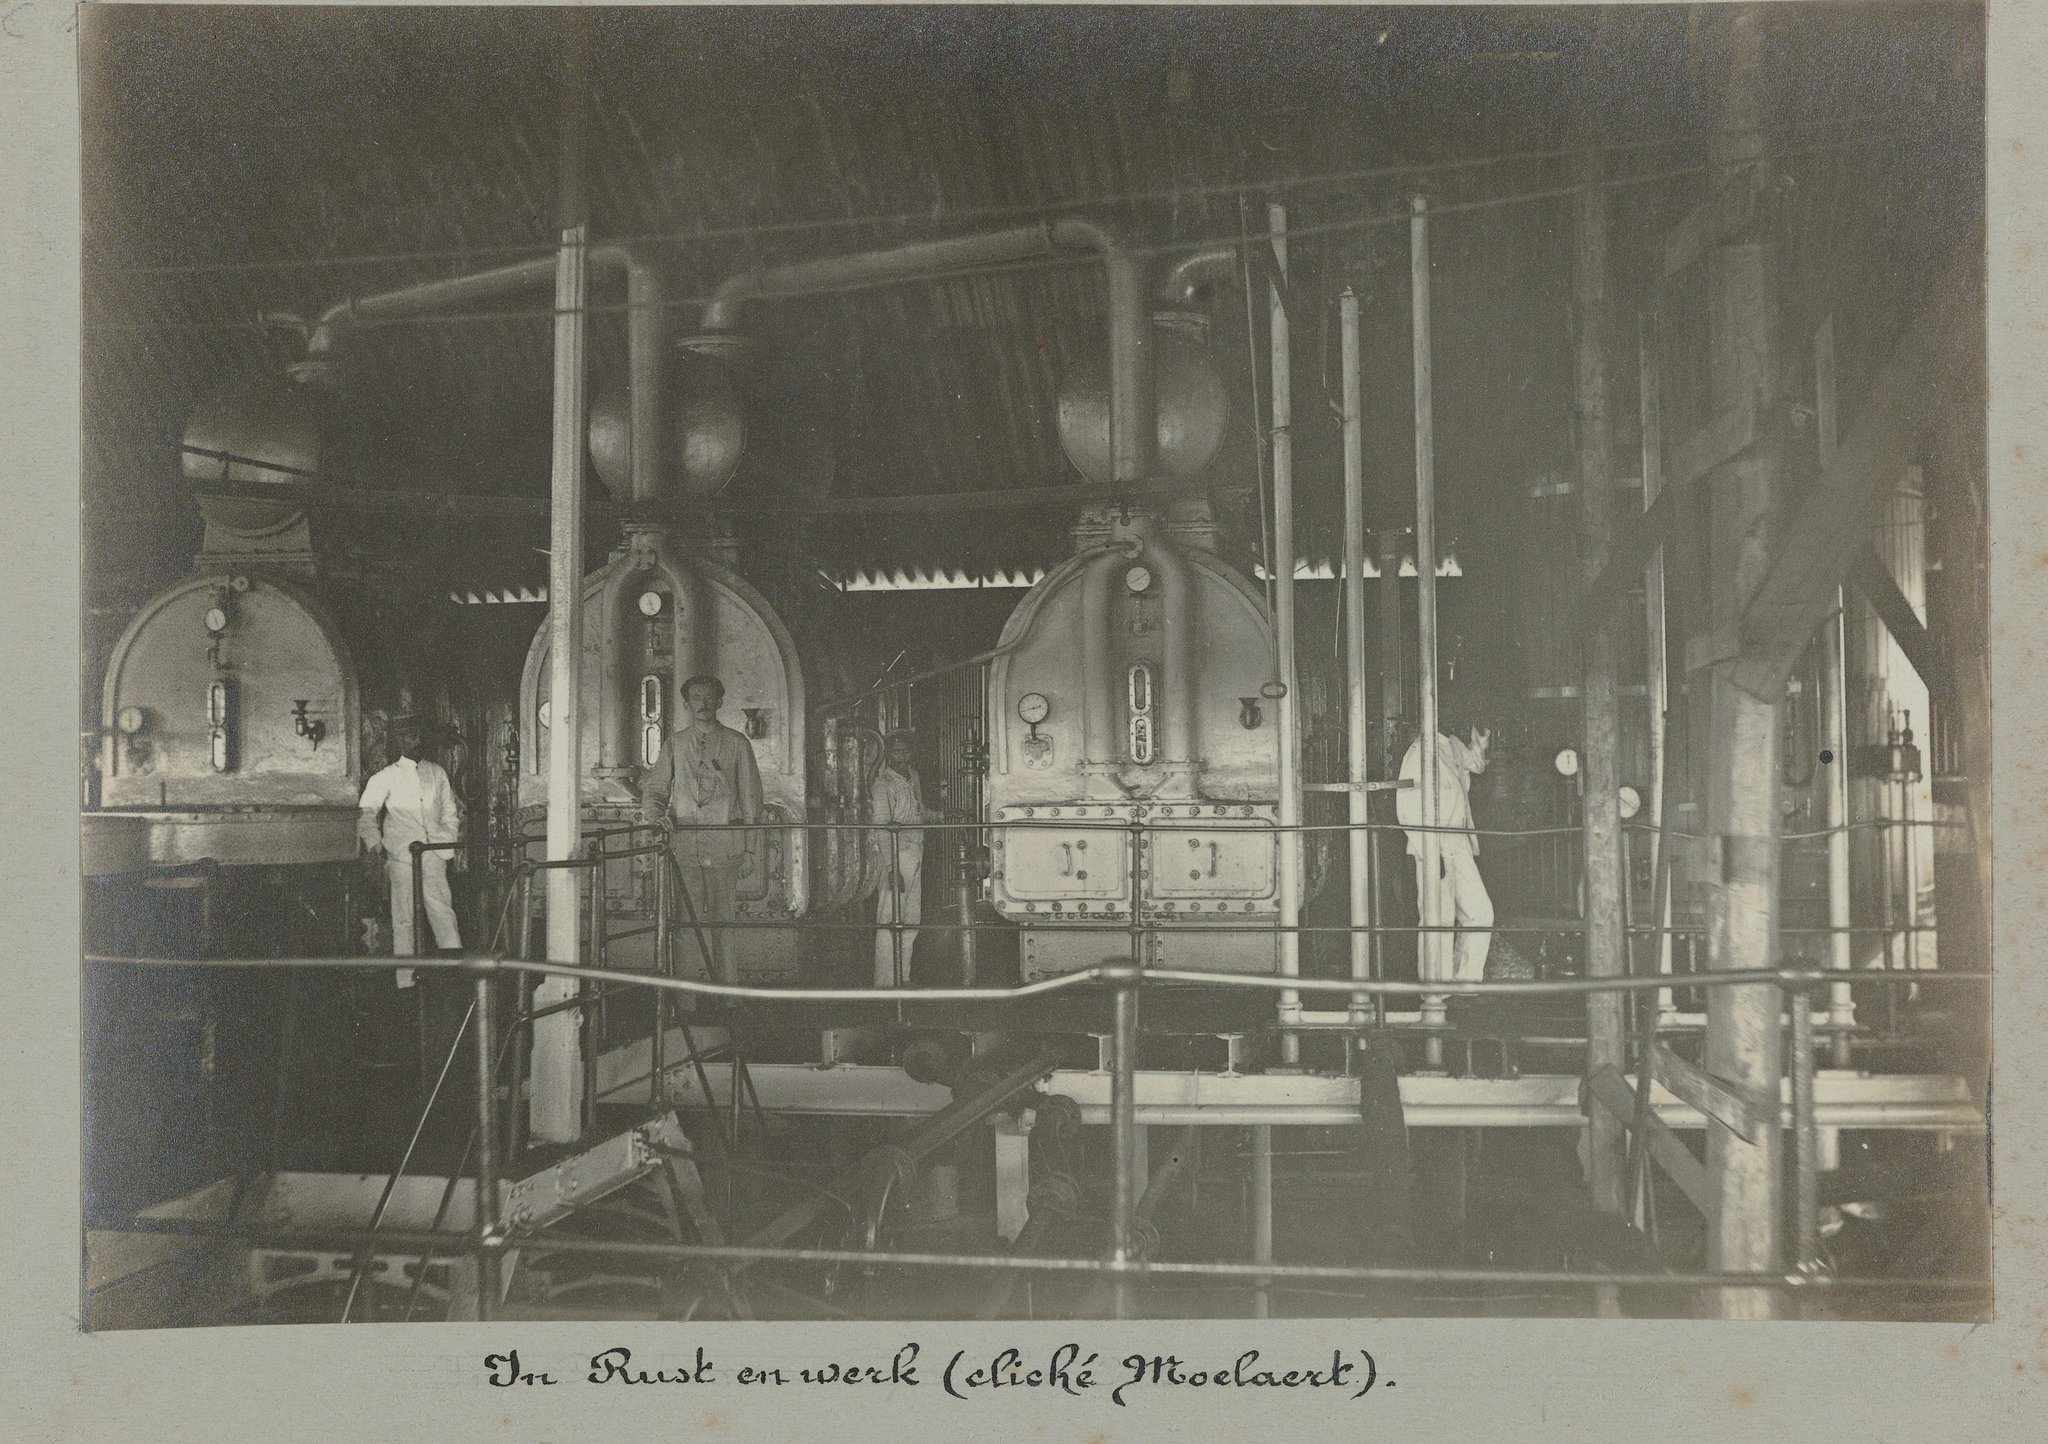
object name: photograph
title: In Rust en werk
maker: hendrik doijer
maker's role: engineer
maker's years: 1863-1925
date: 1903-1910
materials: photographic support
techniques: gelatin silver print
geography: suriname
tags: suriname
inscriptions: inscription: ‘C13 / In Rust en werk (cliché Moelaert).’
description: Gezicht in de suikerfabriek op de Plantage Rust en Werk, vier mannen staande bij de ketels. Onderdeel van het fotoalbum Souvenir de Voyage (deel 2), over het leven van de familie Doijer in en rond de plantage Ma Retraite in Suriname in de jaren 1903-1910.